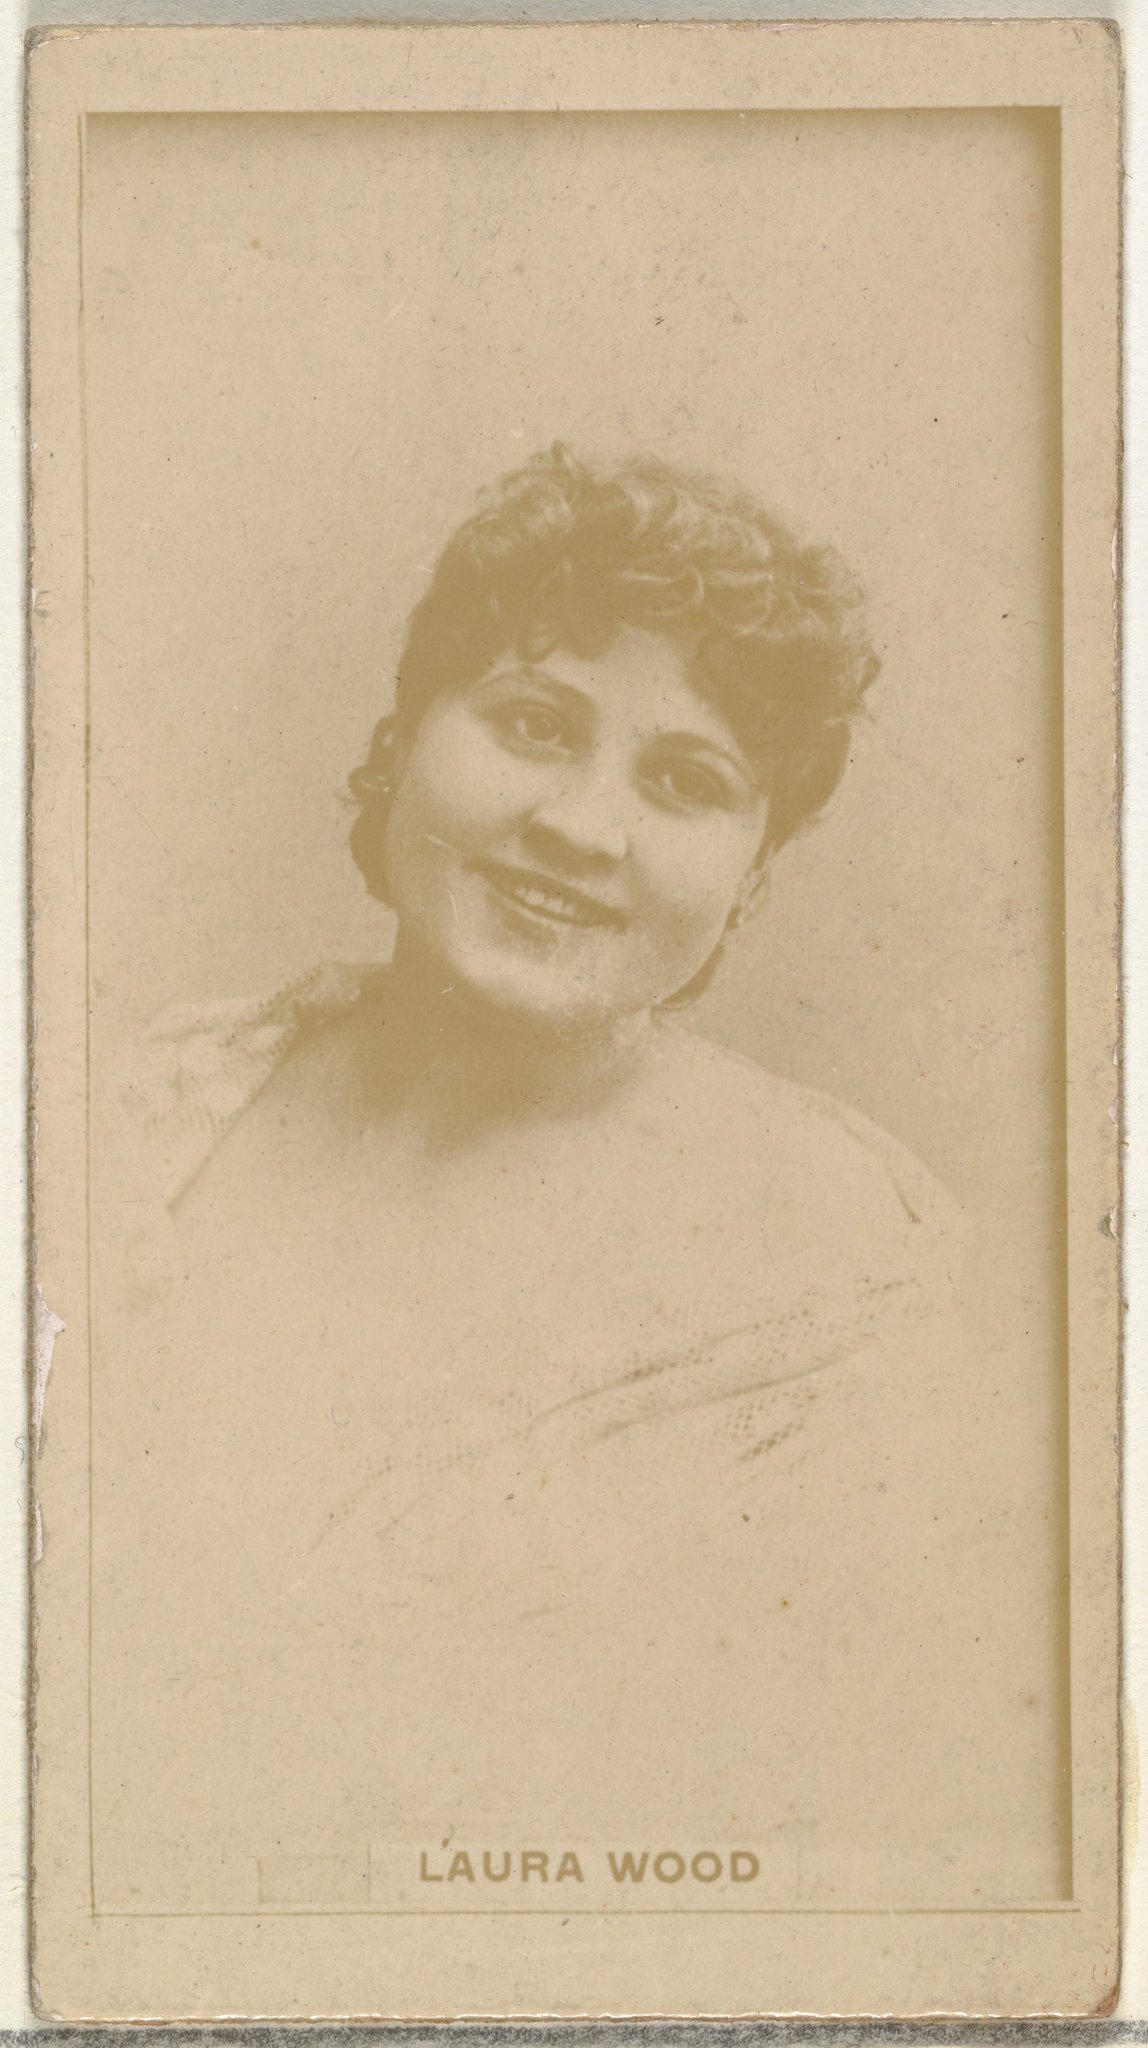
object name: photograph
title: Laura Wood, from the Actors and Actresses series (N145-8) issued by Duke Sons & Co. to promote Duke Cigarettes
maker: w. duke, sons & co.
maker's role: publisher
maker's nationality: american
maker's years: 1870-1920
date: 1891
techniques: albumen silver print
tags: portraits,women,actresses